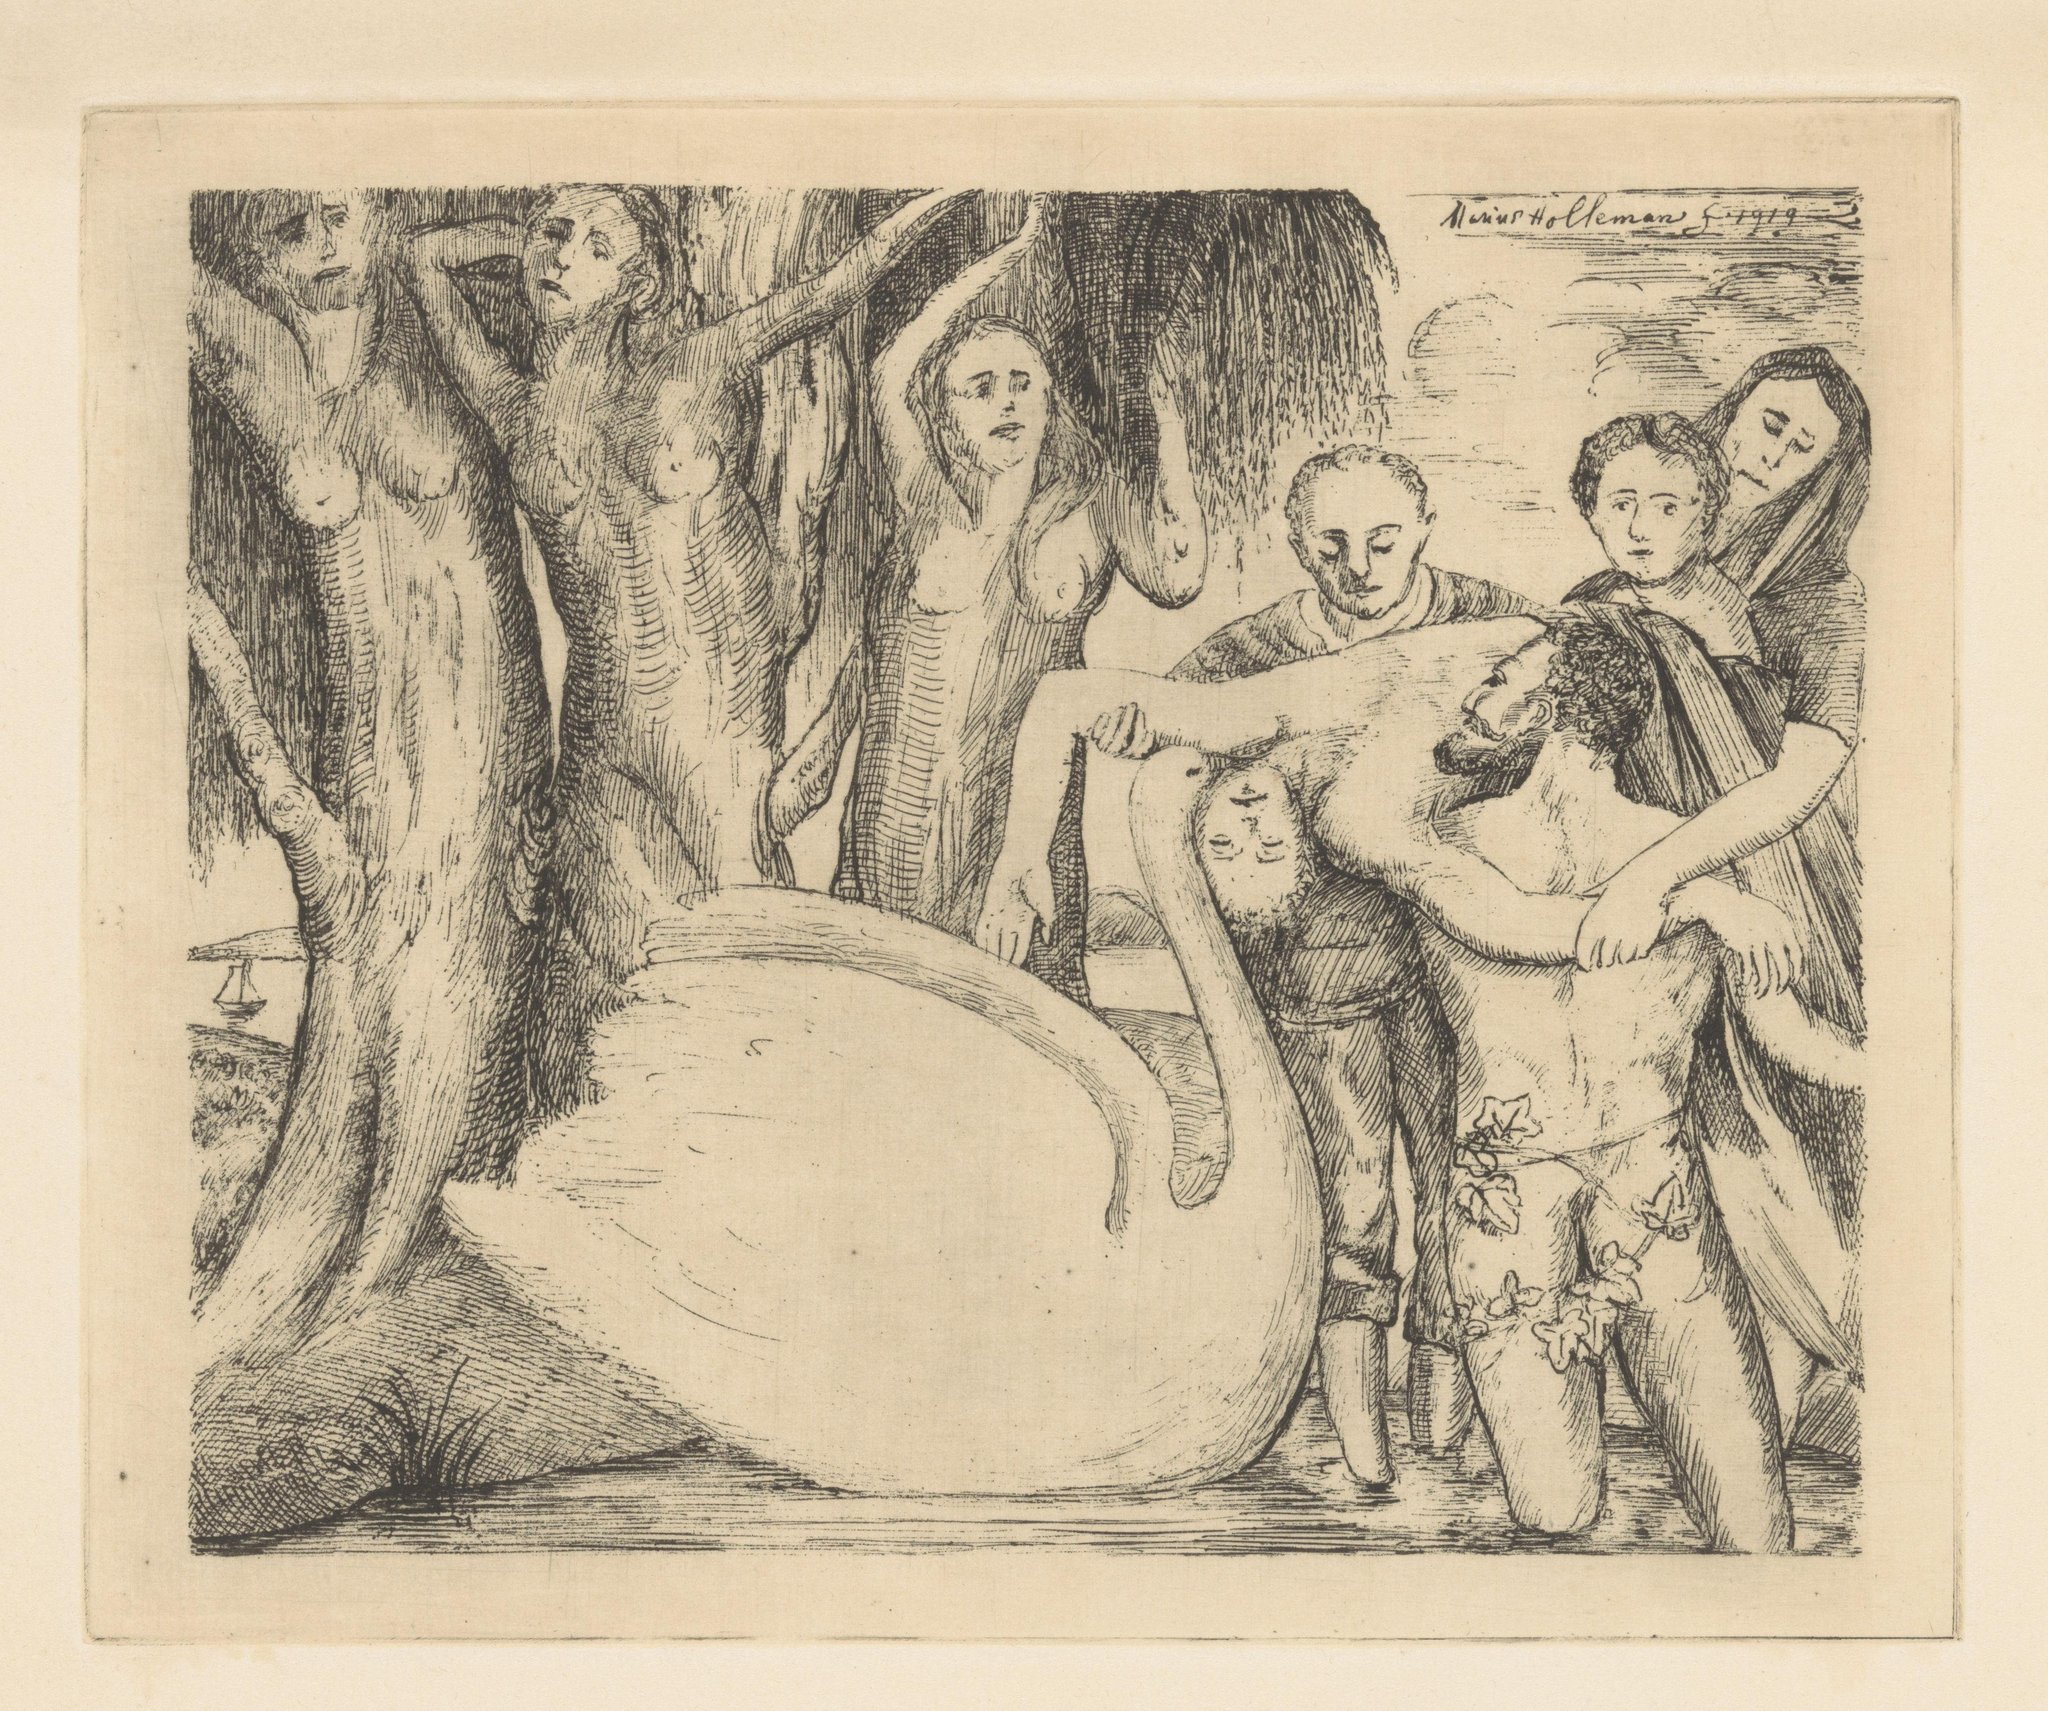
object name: print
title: Leda en de zwaan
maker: marius holleman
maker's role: draughtsman, print maker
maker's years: 1878-1926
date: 1919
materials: paper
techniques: etching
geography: groningen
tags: cycnus, son of sthenelus, changed into a swan: while grieving over the death of phaethon, cycnus, son of sthenelus, is changed into a swan (ovid, metamorphoses ii 373), heliades changed into poplar-trees: while weeping over phaeton's grave the heliades are changed into poplar-trees, and their tears turn into beads of amber; their mother clymene may be present (ovid, metamorphoses ii 346)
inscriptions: collector's mark: Lugt 2228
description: In het midden Cygnus als zwaan. Rechts rouwt een groep mensen bij het lichaam van Phaëton. Links op de oever van de rivier de rouwende Heliaden die zijn veranderd in bomen.